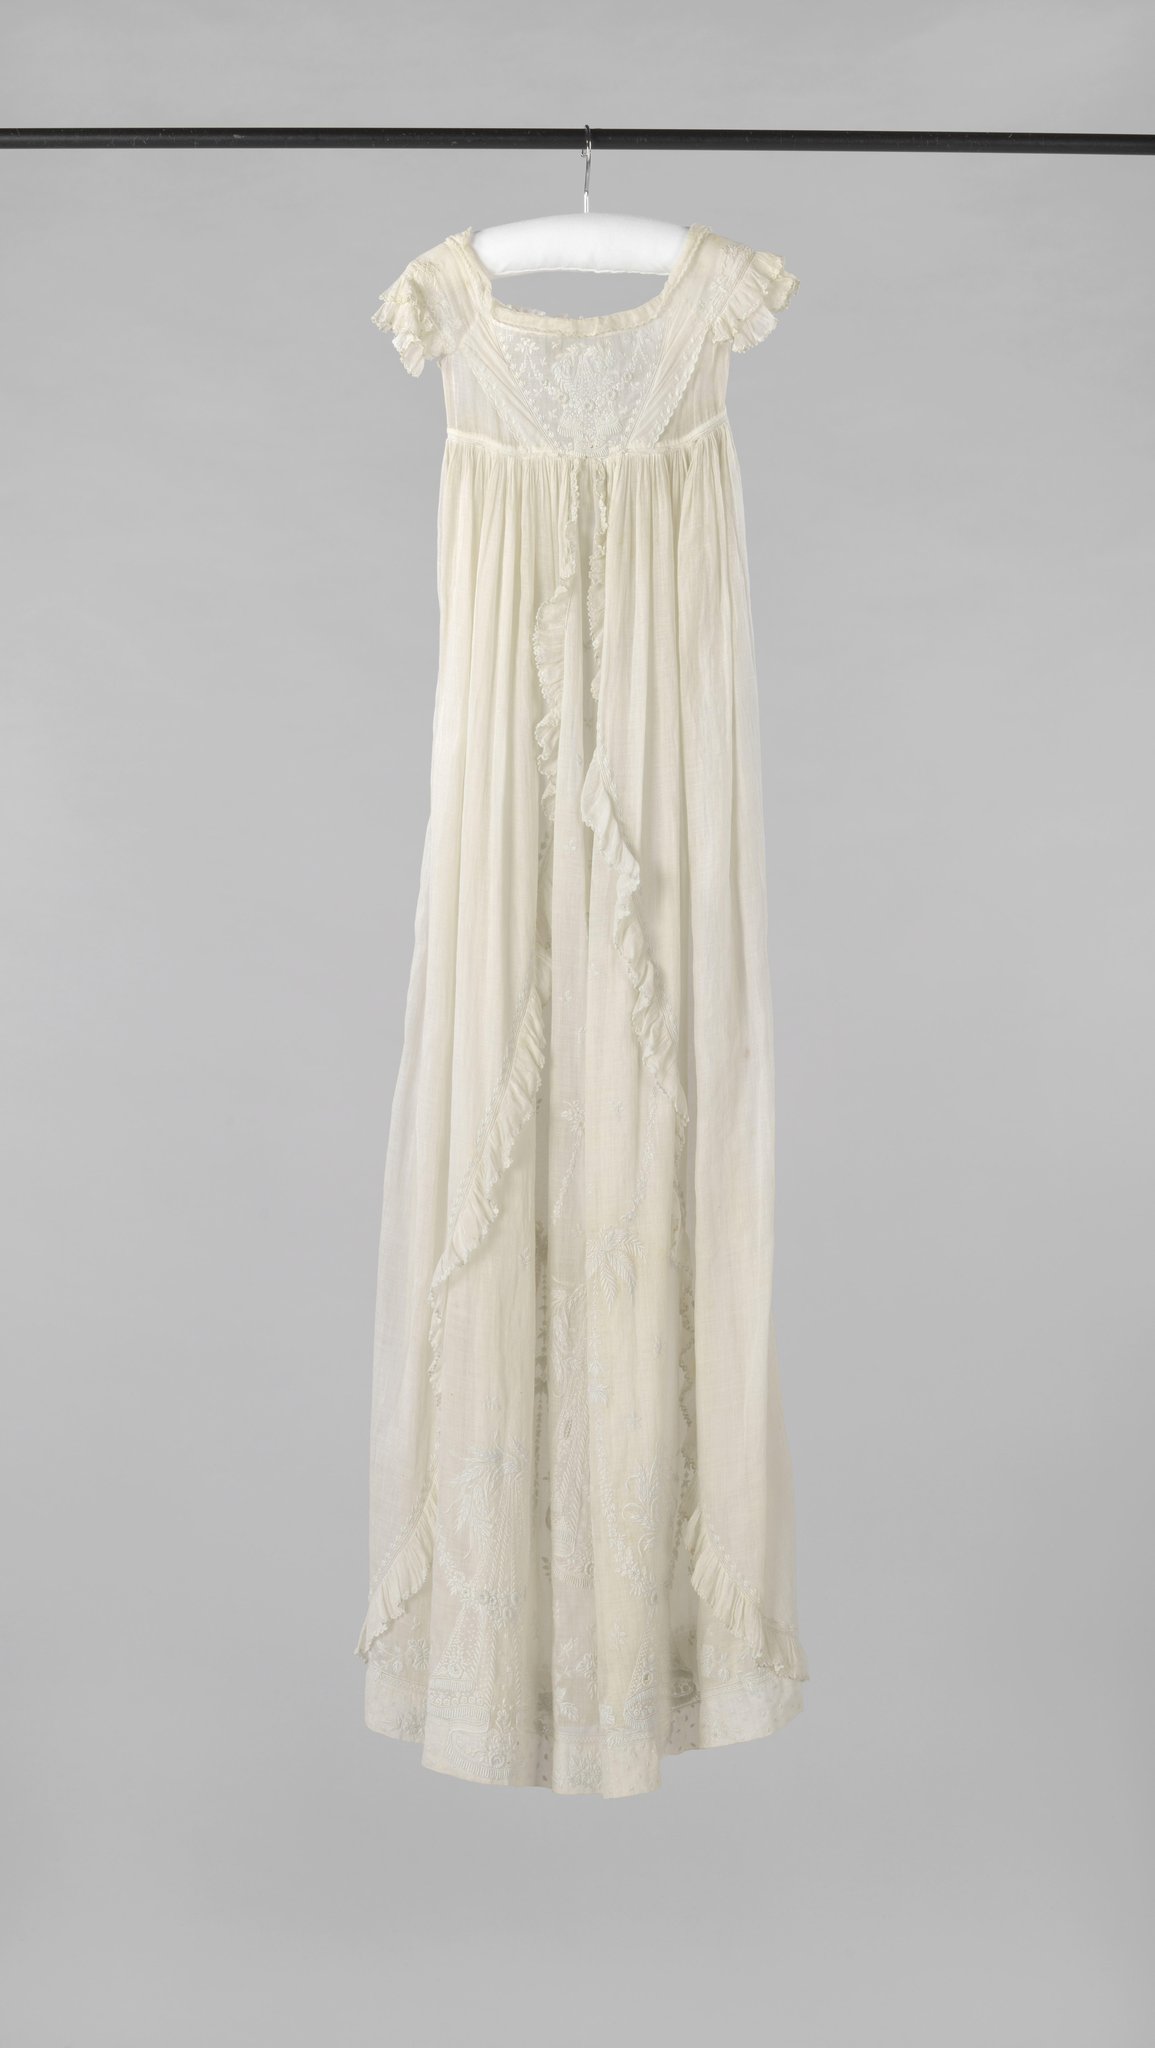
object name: childrenswear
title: Een doopjurk van batist met borduurwerk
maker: Anonymous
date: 1850-1875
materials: textile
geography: netherlands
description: Een doopjurk van batist met borduurwerk.